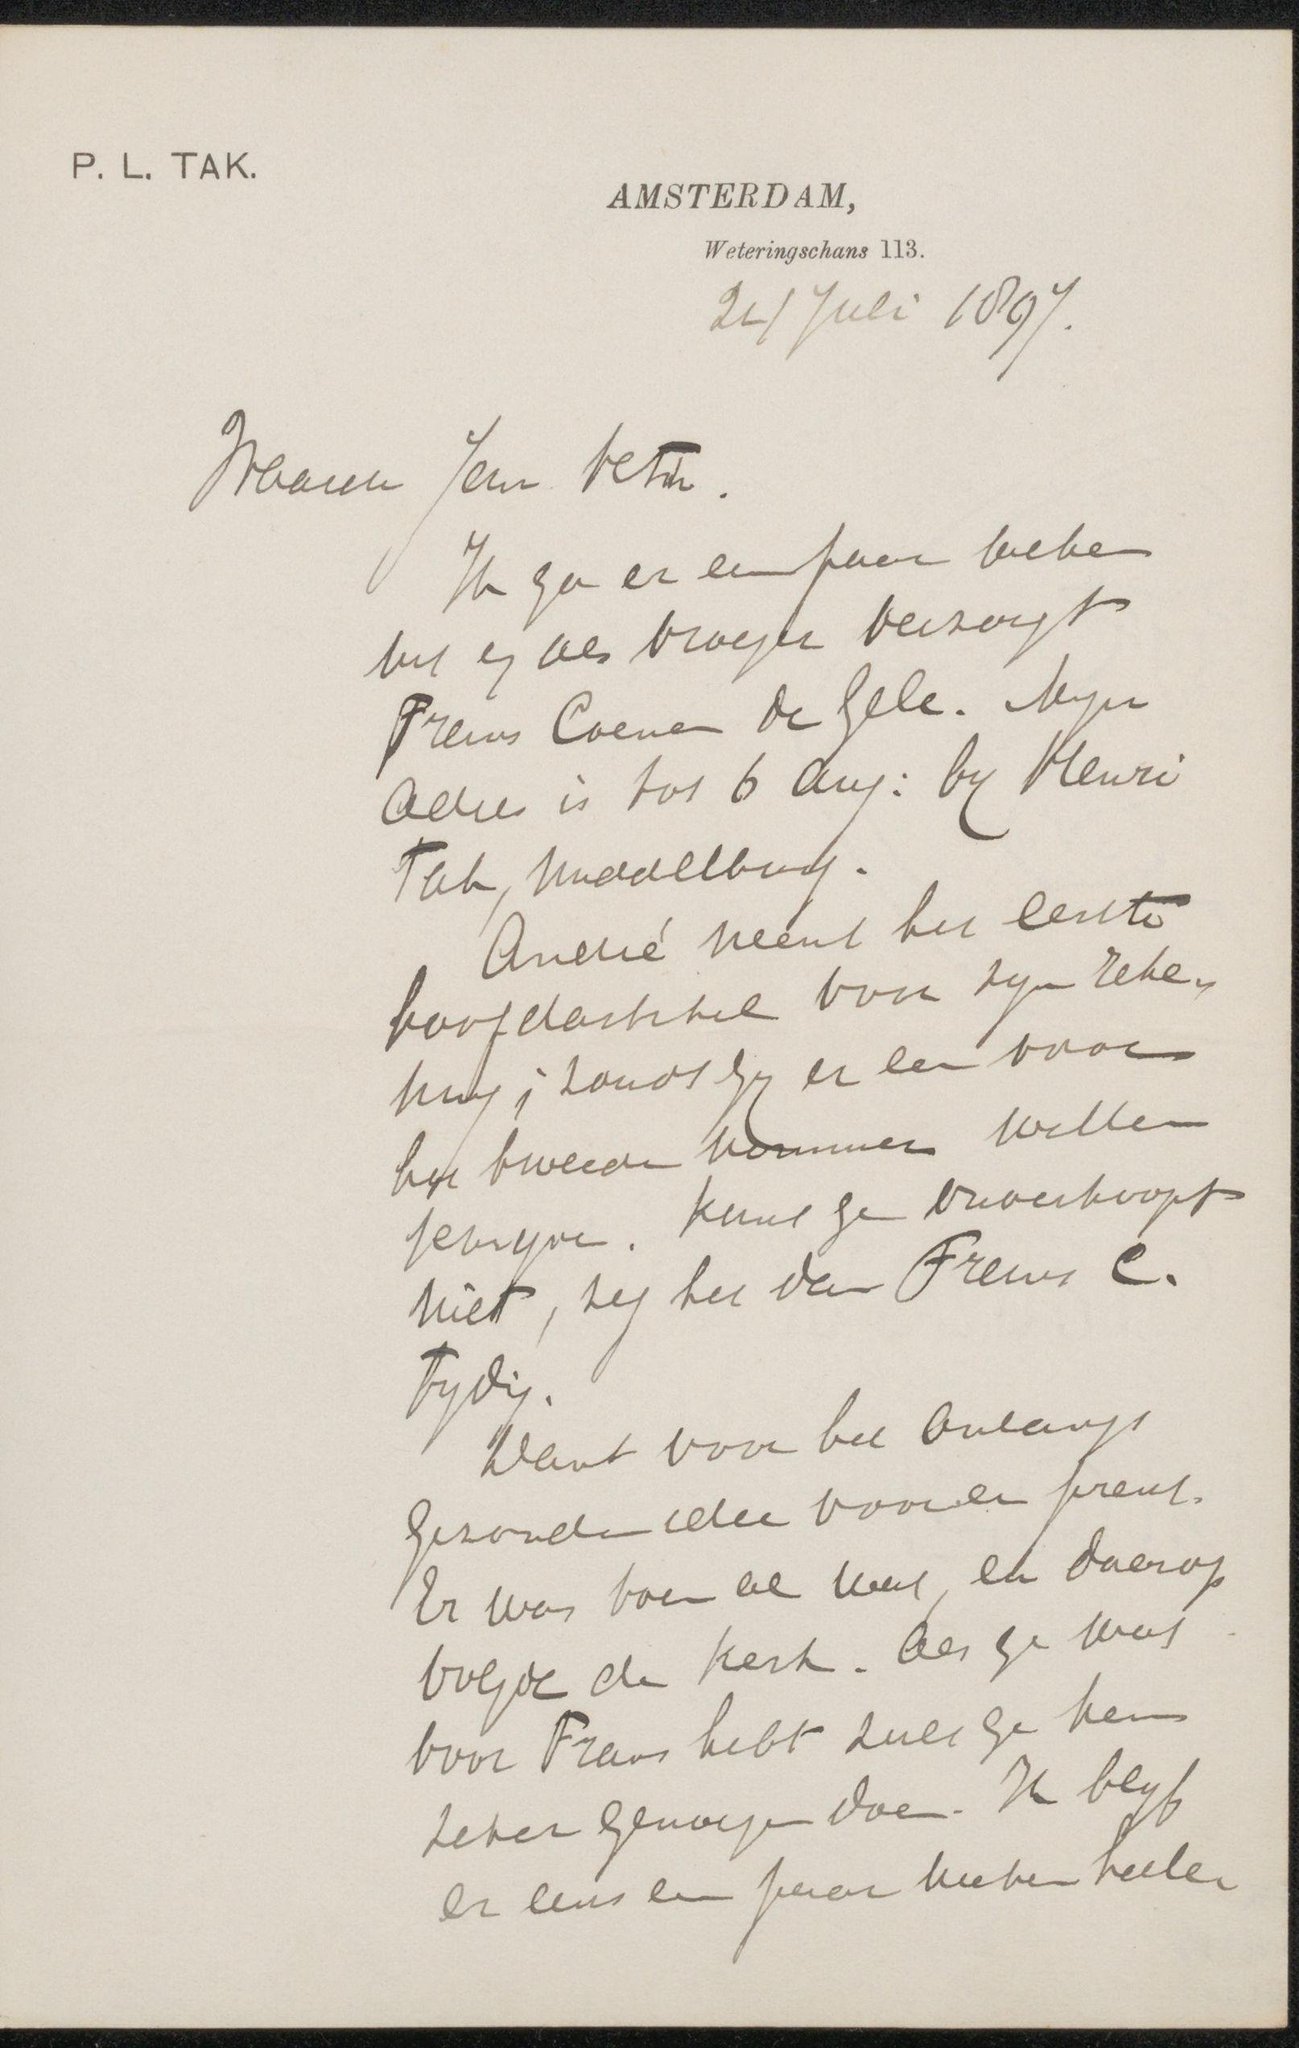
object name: letter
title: Brief aan Jan Veth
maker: pieter lodewijk tak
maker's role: politician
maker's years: 1848-1907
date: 1897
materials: ink, paper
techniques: pen, printing, writing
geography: amsterdam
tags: dordrecht, painter, draughtsman, designer, jan veth, andré jolles, leiden, the graphic arts, historical persons (portraits and scenes from the life), printed matter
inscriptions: watermark, collector's mark: ‘RPK’